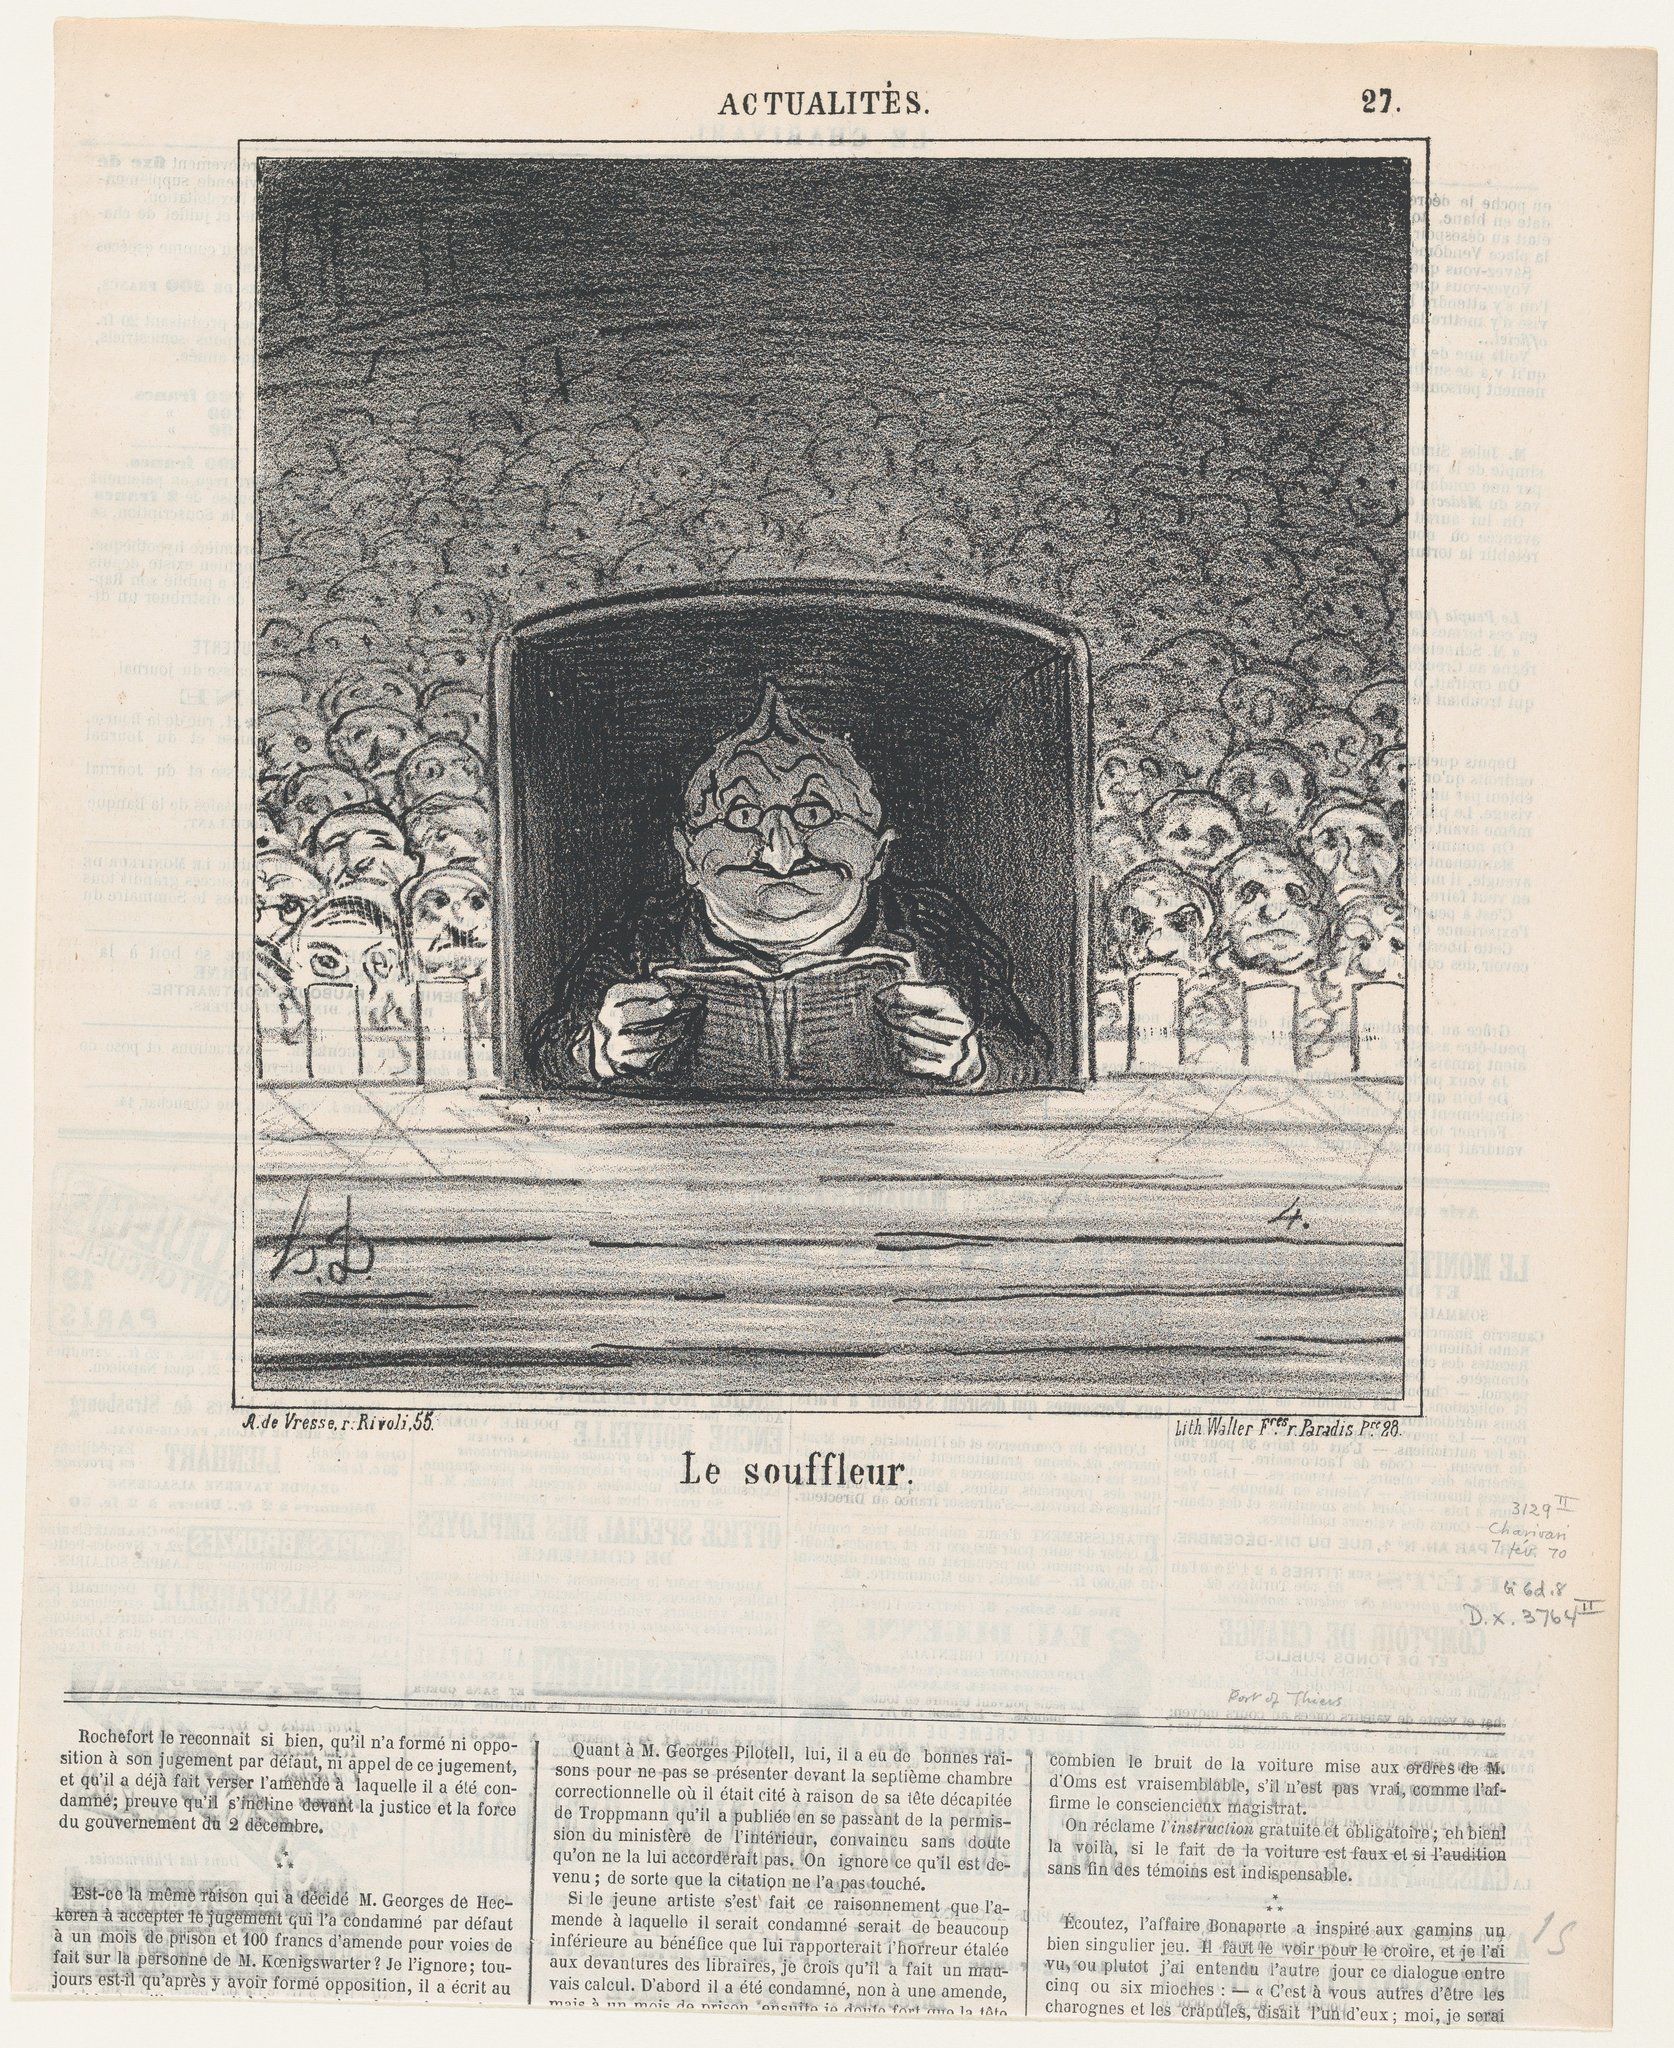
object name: print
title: The prompter, from 'News of the day,' published in Le Charivari, February 7, 1870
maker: honoré daumier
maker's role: artist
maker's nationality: french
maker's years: 1808-1879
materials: paper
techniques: lithograph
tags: men,reading,crowd